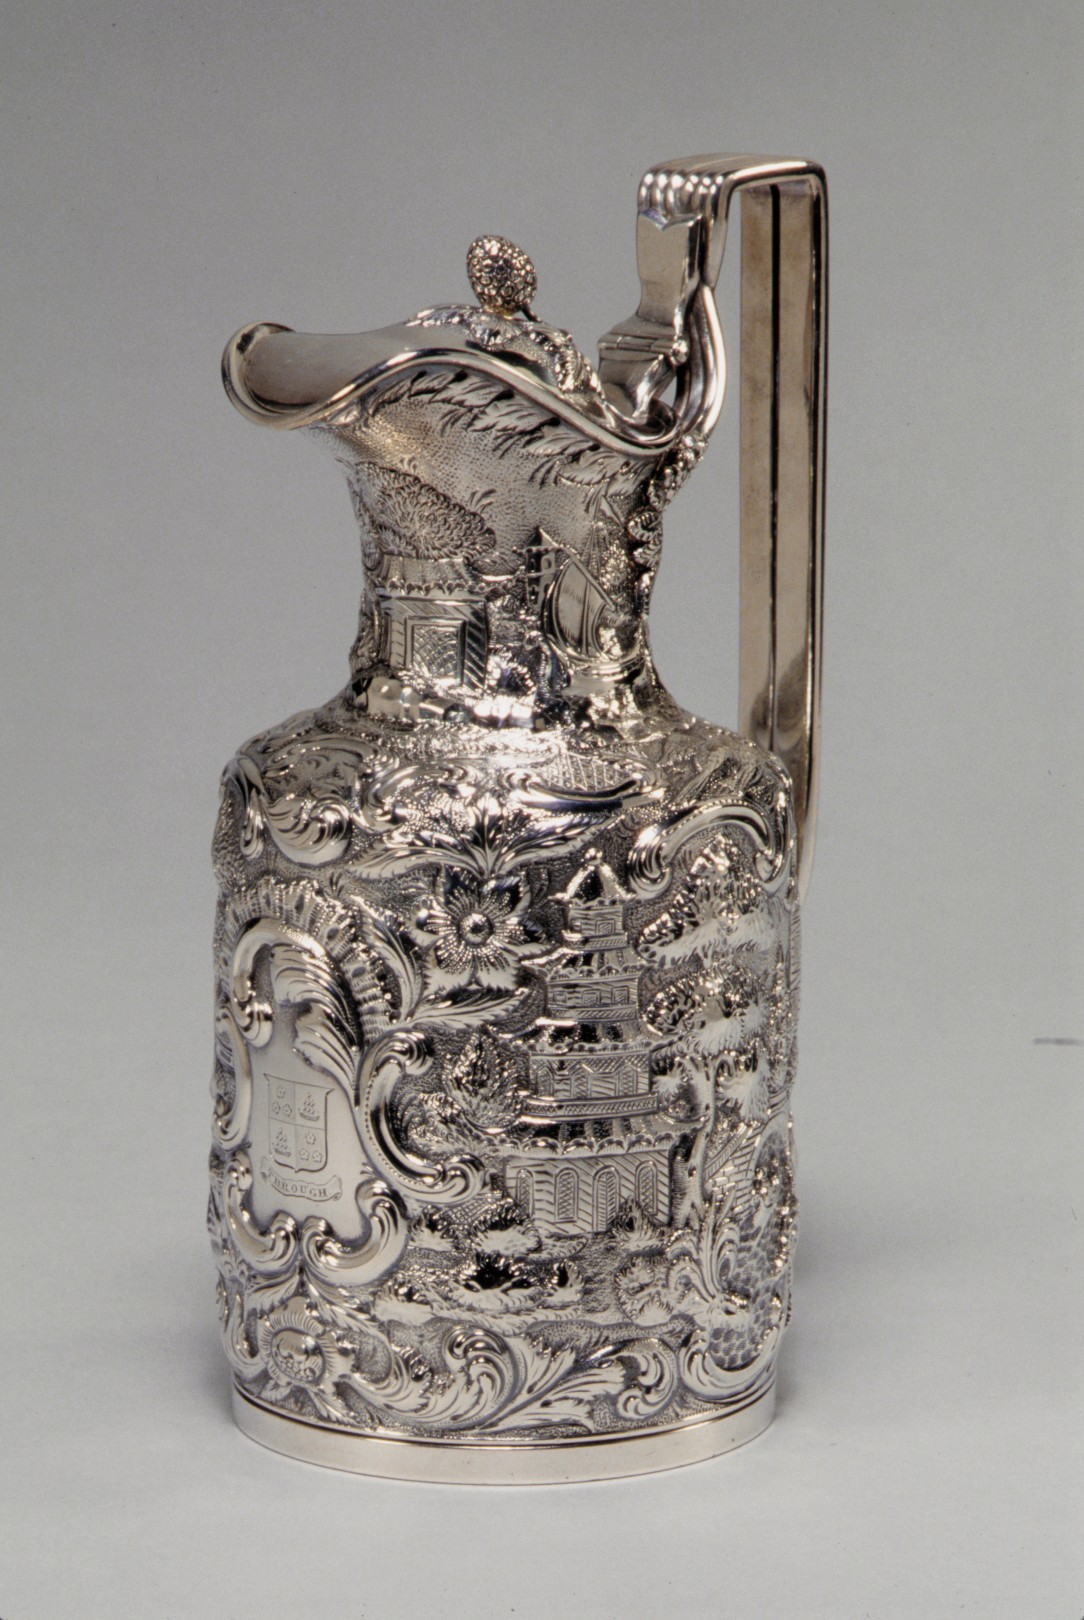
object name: milk pot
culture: american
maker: andrew ellicott warner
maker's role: maker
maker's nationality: american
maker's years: 1786-1870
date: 1845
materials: silver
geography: united states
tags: flowers,coat of arms